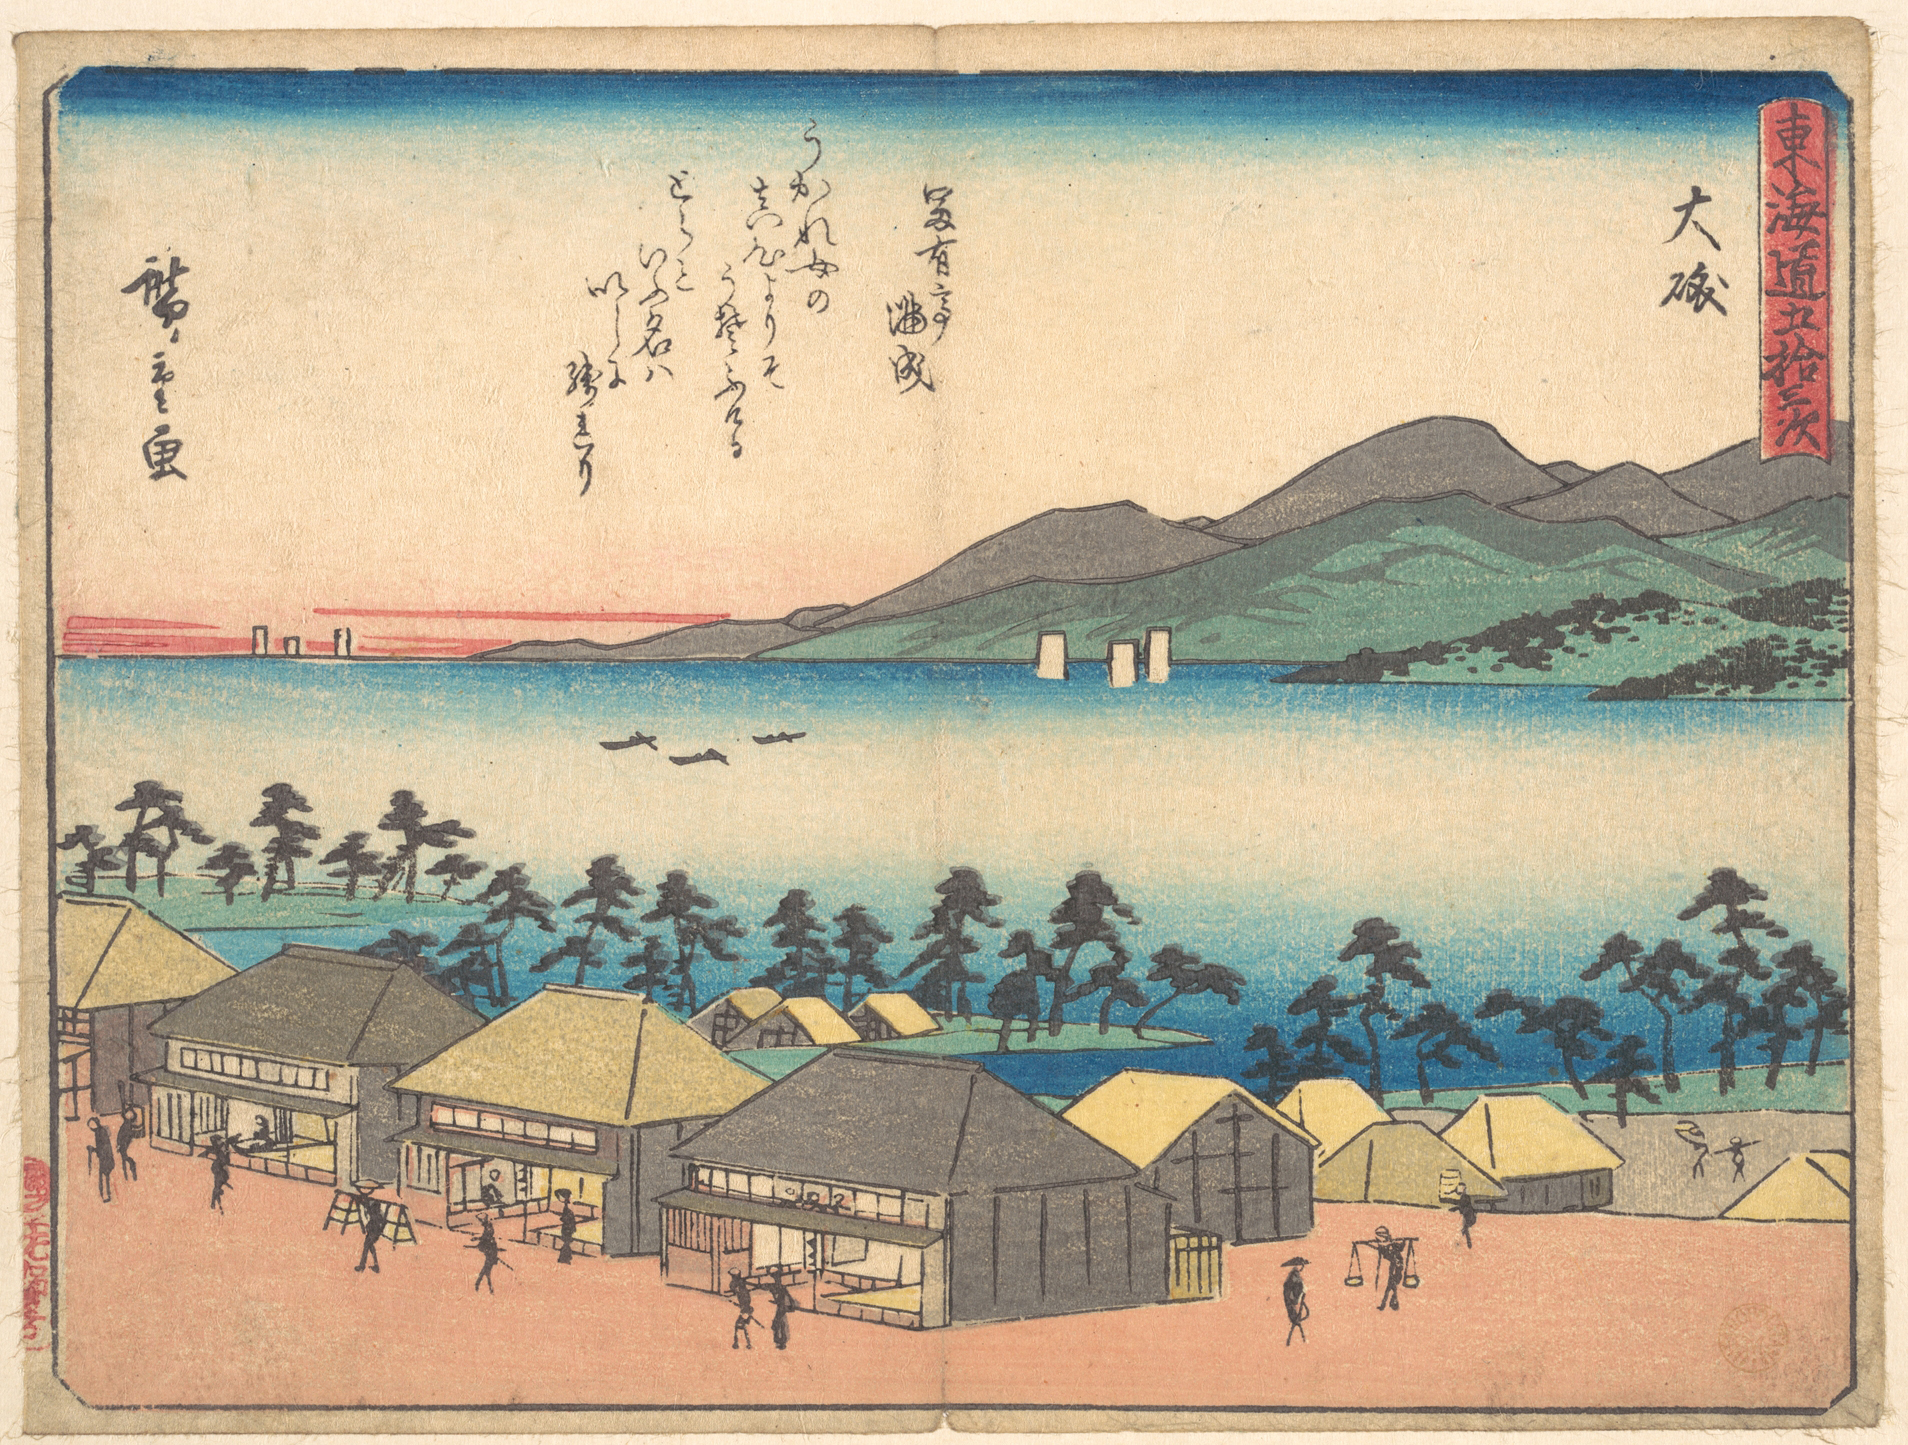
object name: print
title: Ōiso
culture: japanese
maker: utagawa hiroshige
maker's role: artist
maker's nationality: japanese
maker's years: 1797-1858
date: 1838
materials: ink, paper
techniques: woodblock print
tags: landscapes